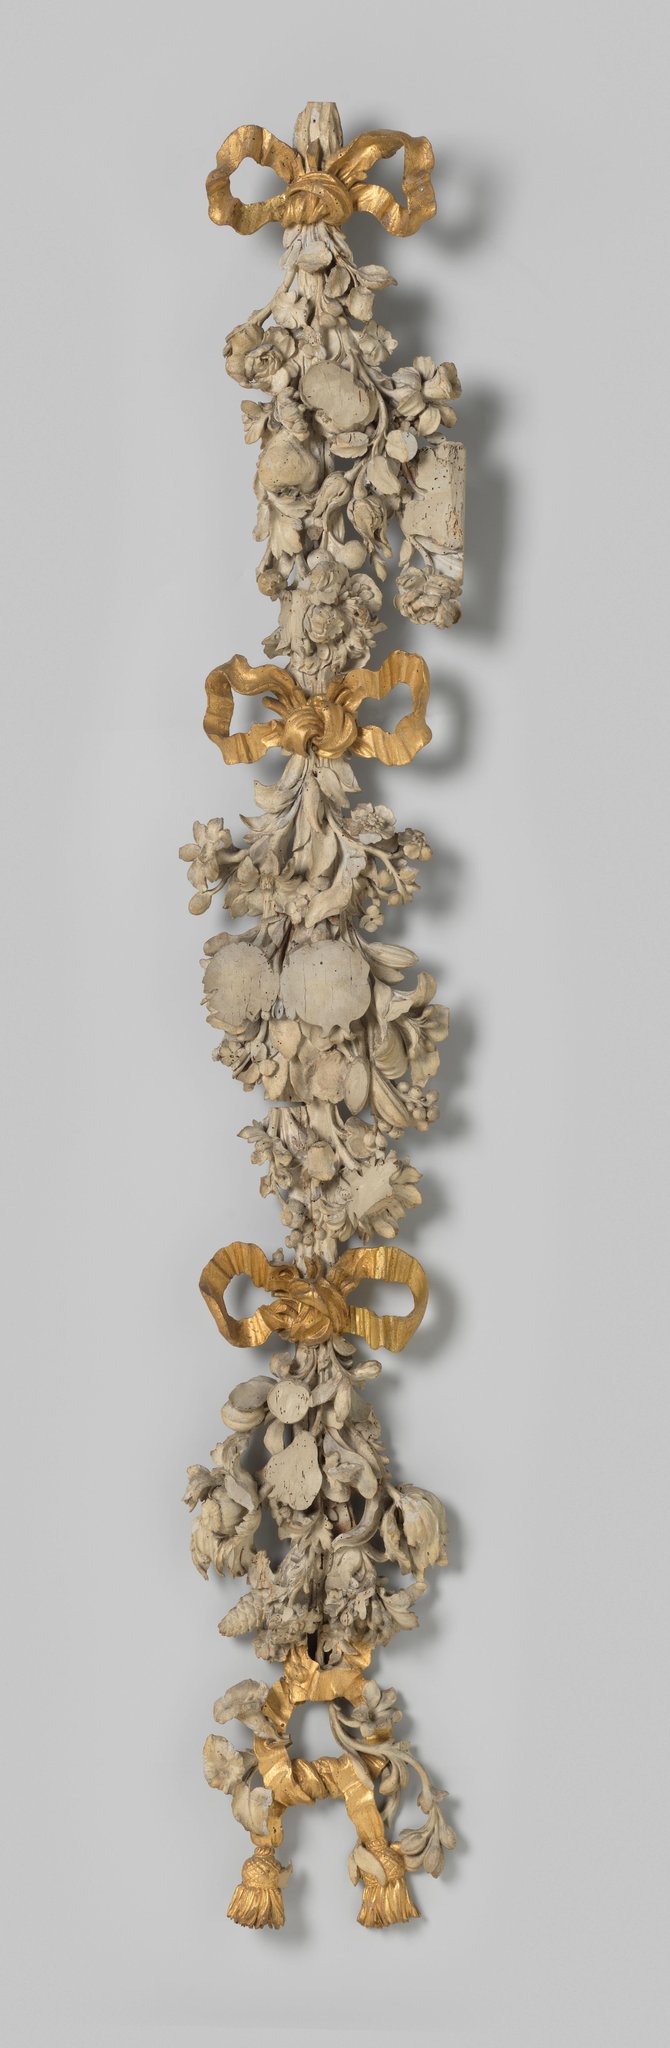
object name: woodcarving visual work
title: Guirlande met bloemen en vruchten van verguld en beschilderd lindehout, afkomstig uit Huis de Voorst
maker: Anonymous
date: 1700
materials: wood, paint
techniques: gilding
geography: northern netherlands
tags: huis de voorst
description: Guirlande met bloemen en vruchten van verguld en beschilderd lindehout.